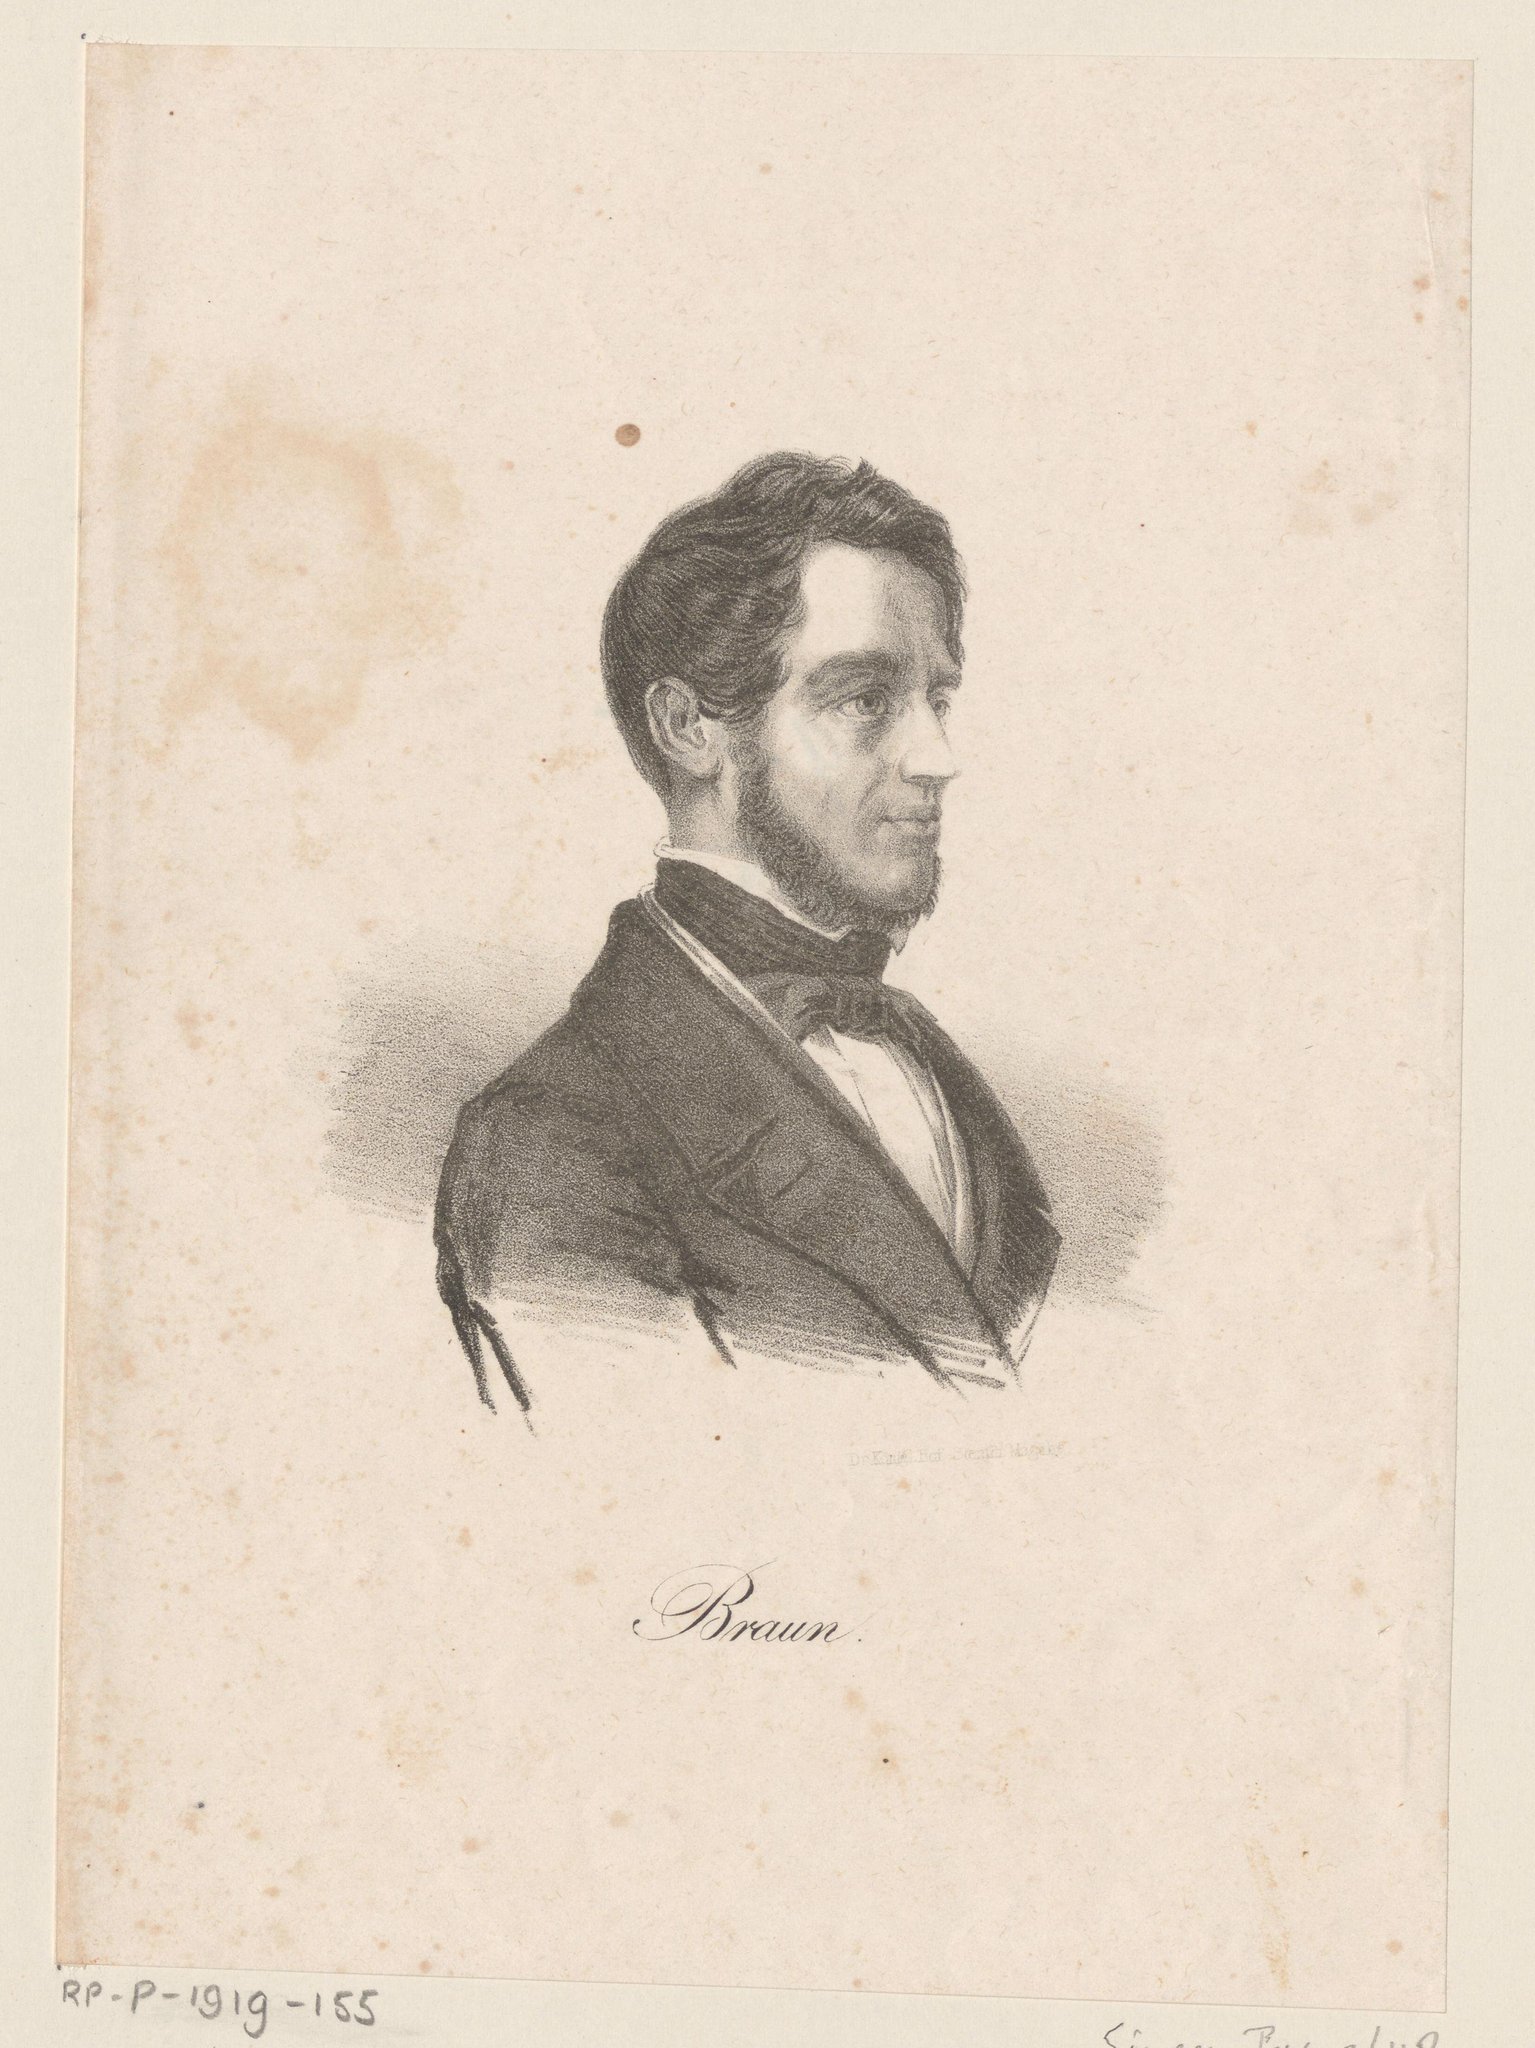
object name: print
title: Portret van Alexander Karl Hermann Braun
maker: Anonymous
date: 1840-1875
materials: paper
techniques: lithograph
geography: magdeburg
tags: politician, historical persons, politician, e.g. party leader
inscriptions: collector's mark: Lugt 2228